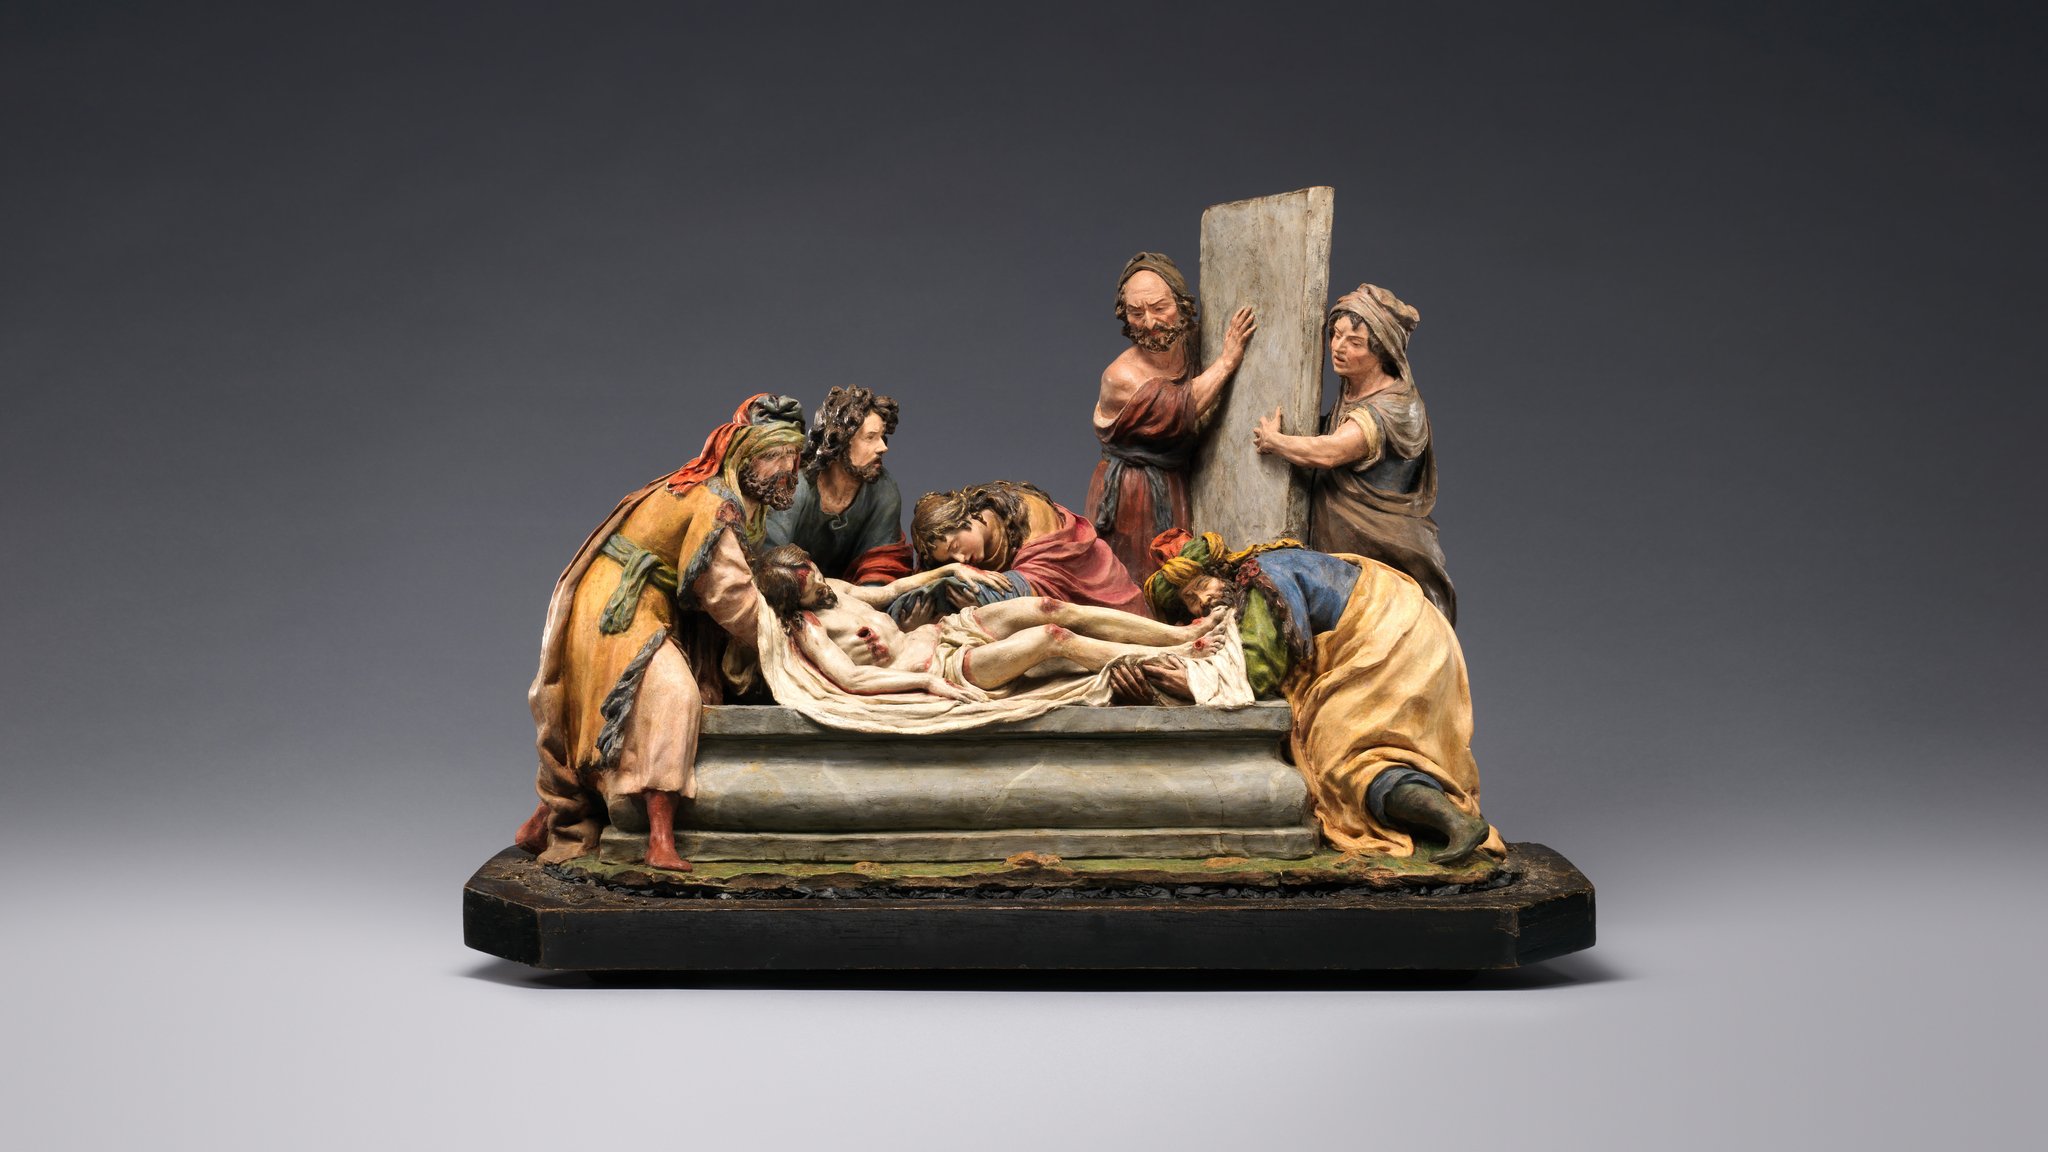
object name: statuette group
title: The Entombment of Christ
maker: luisa roldán, called la roldana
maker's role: artist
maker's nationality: spanish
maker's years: 1652-1706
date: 1700-1701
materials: terracotta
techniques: polychrome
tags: christ,mary magdalene,entombment